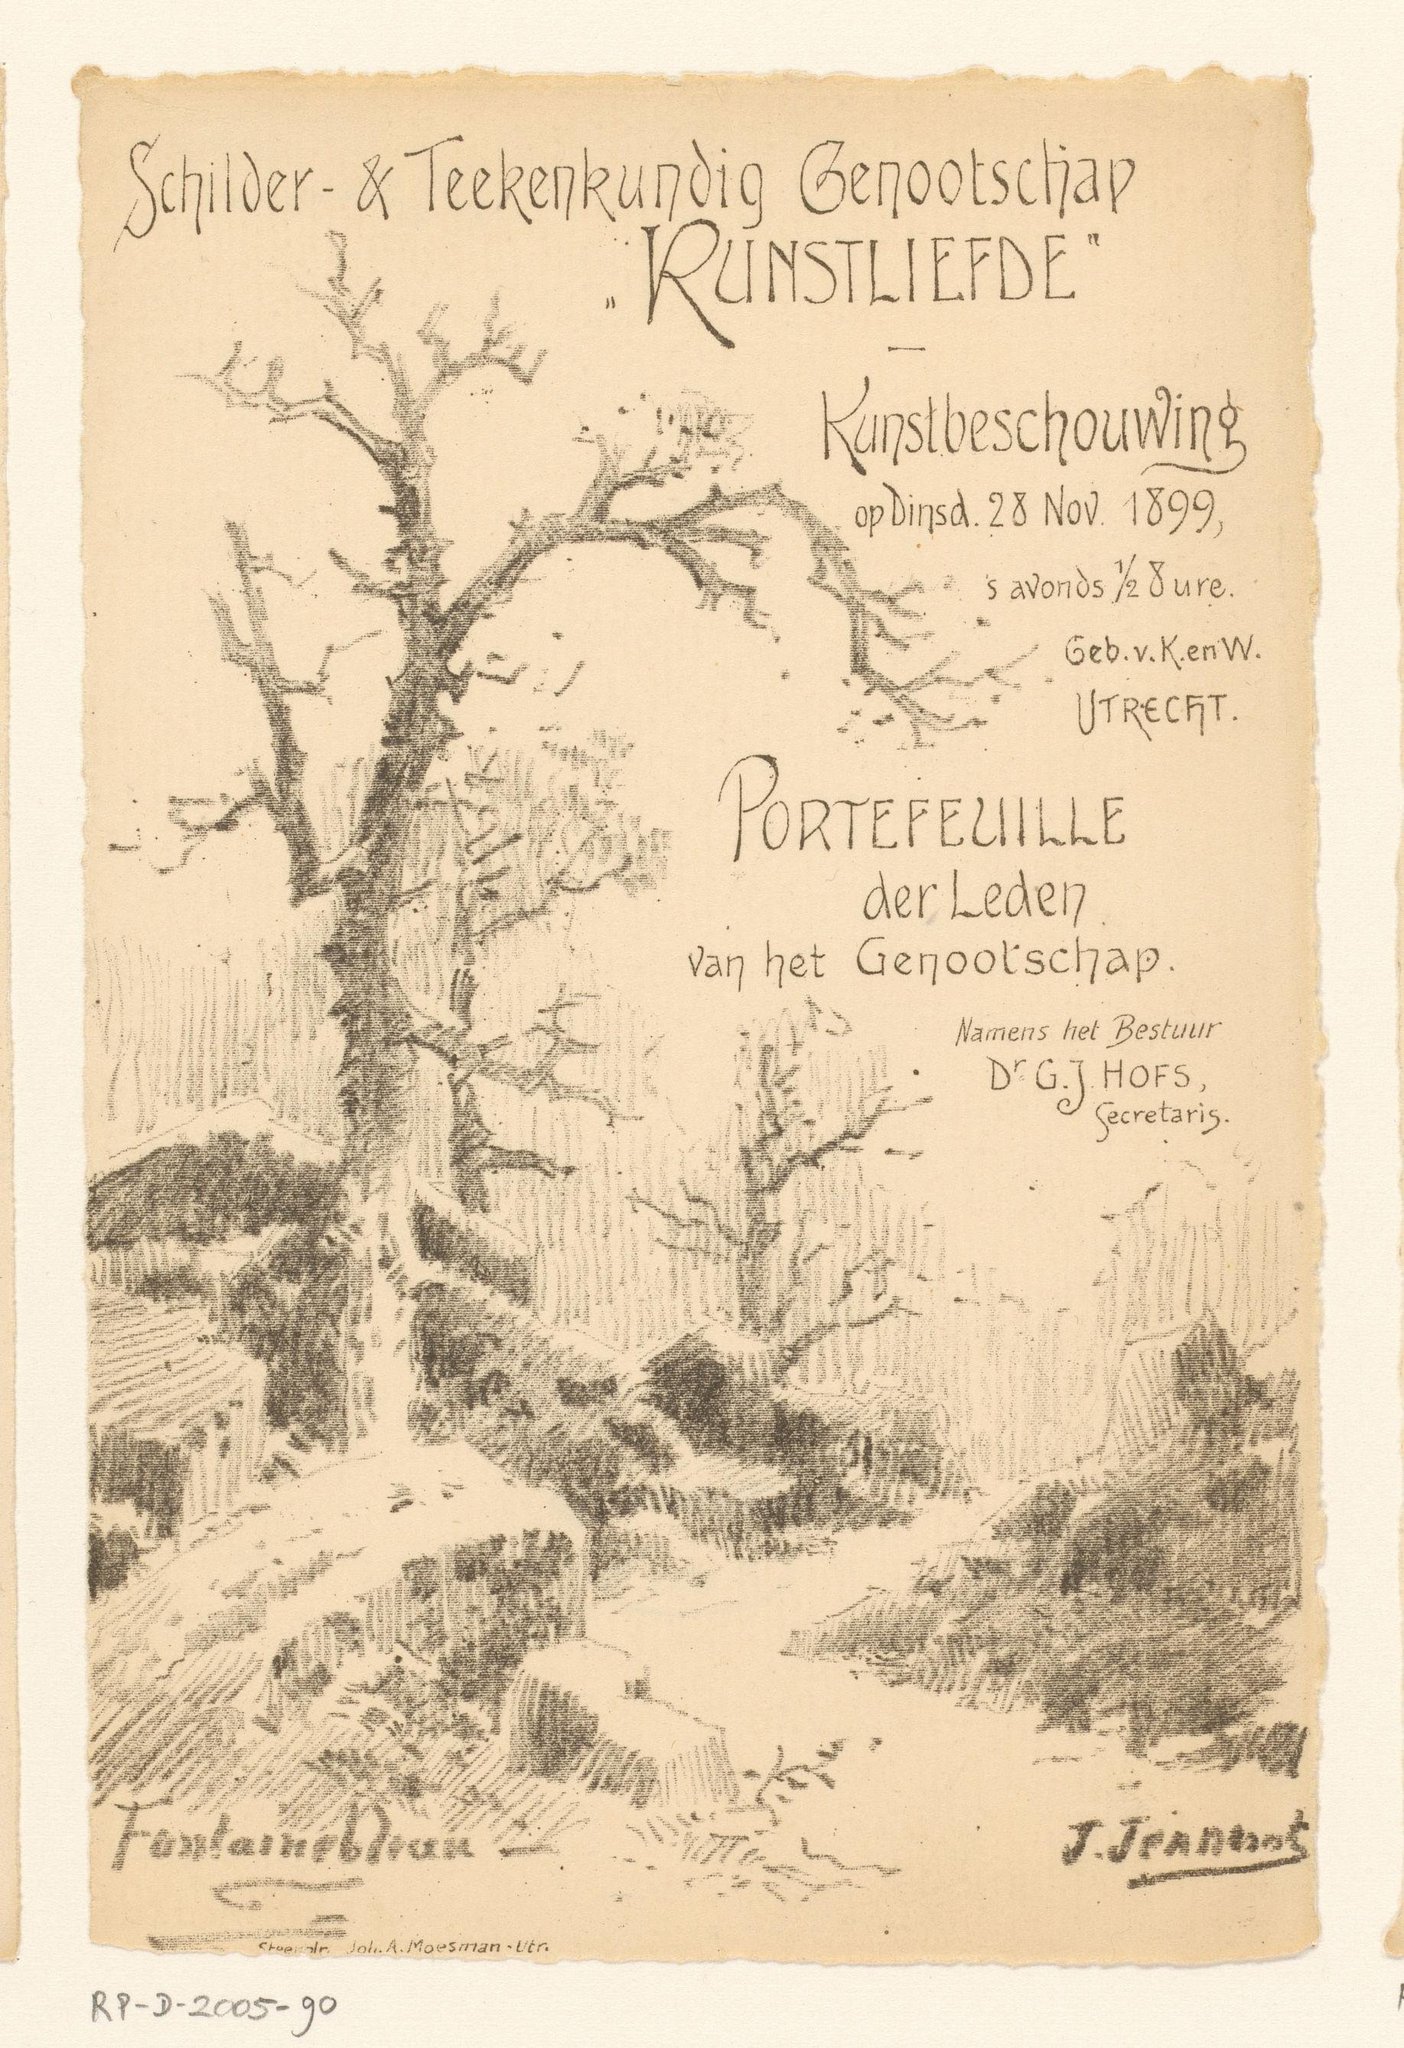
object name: invitation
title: Uitnodiging van Schilder- en Teekenkundig Genootschap "Kunstliefde" voor een kunstbeschouwing, 28 november 1899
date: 1811-1899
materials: paper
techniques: lithograph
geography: utrecht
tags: criticizing and discussing art, art criticism, circle, club of artists, collecting and exhibiting products of the fine arts, forest, wood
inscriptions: collector's mark: Lugt 2228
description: Kale bomen tussen rotsen, Fontainebleau. Uitnodiging van Schilder- en Teekenkundig Genootschap "Kunstliefde" voor een kunstbeschouwing op 28 november 1899 van de portefeuille van de leden. In het Gebouw voor Kunsten en Wetenschappen te Utrecht.